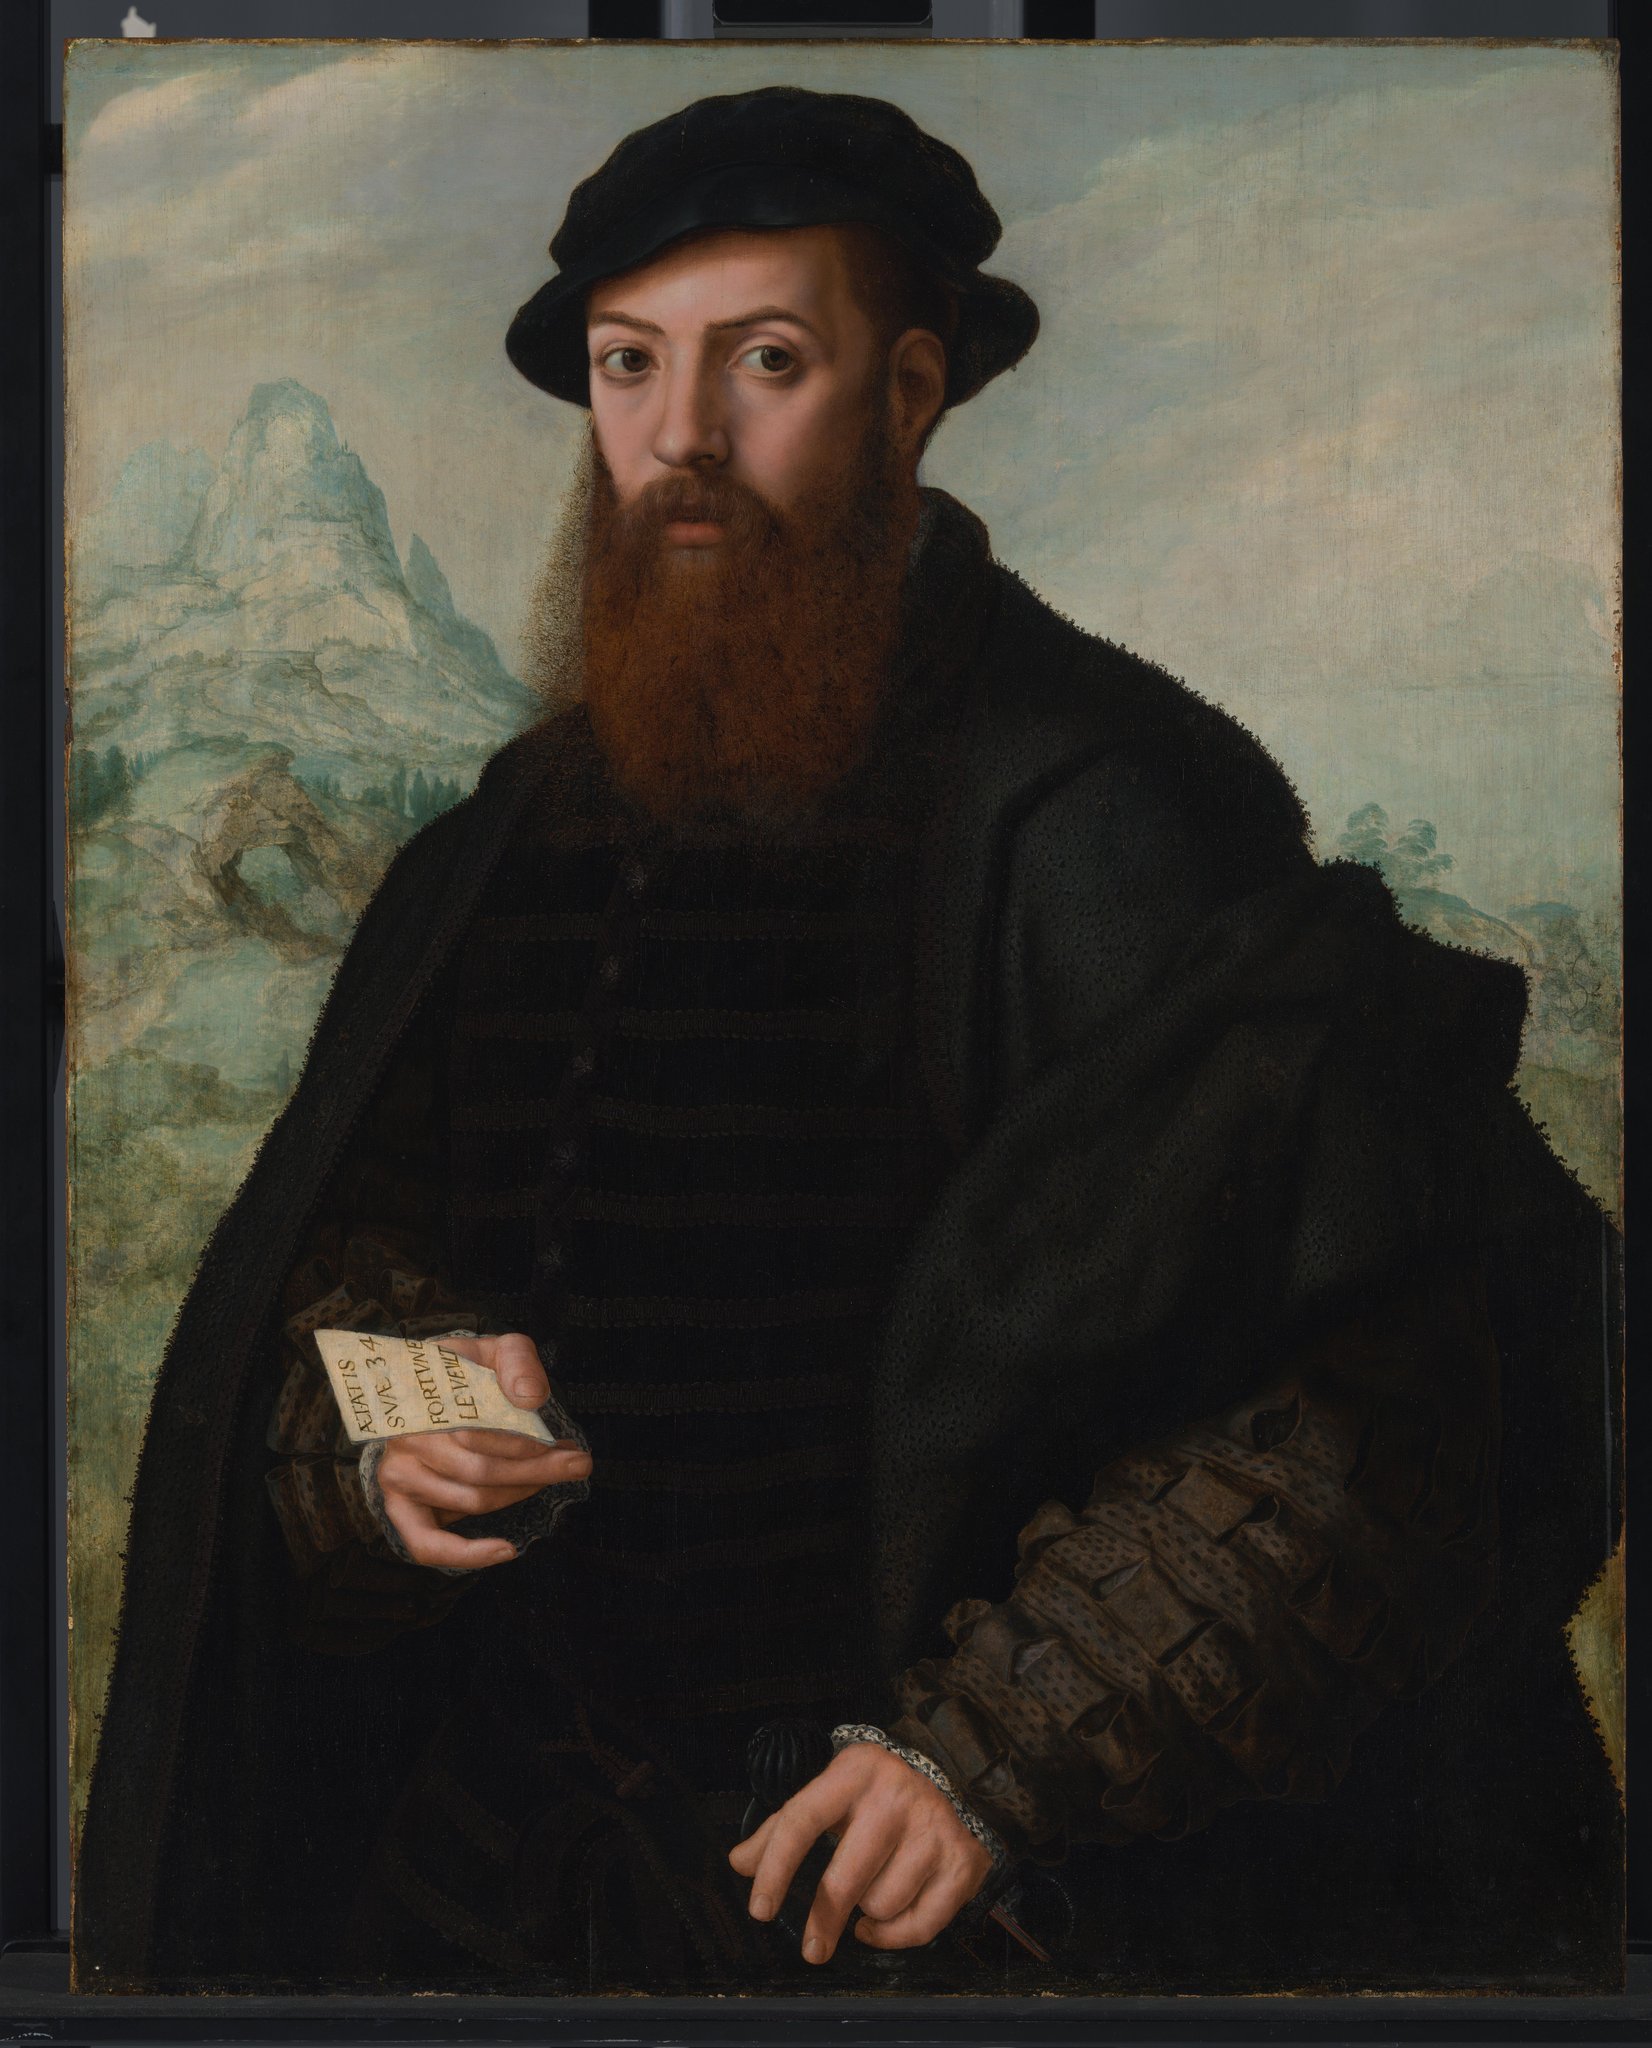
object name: painting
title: Portret van een man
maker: jan van hemessen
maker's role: painter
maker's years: 1500-1575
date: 1535-1540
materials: oil, paint, panel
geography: antwerp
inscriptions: inscription: ‘inventarisnummer 178’, stamp: ‘koninklijke insignes van Willem, Prins van Oranje (1792-1849)’, inscription: ‘ÆTATIS / SVAE 34 / FORTVNE / LE VEVLT’